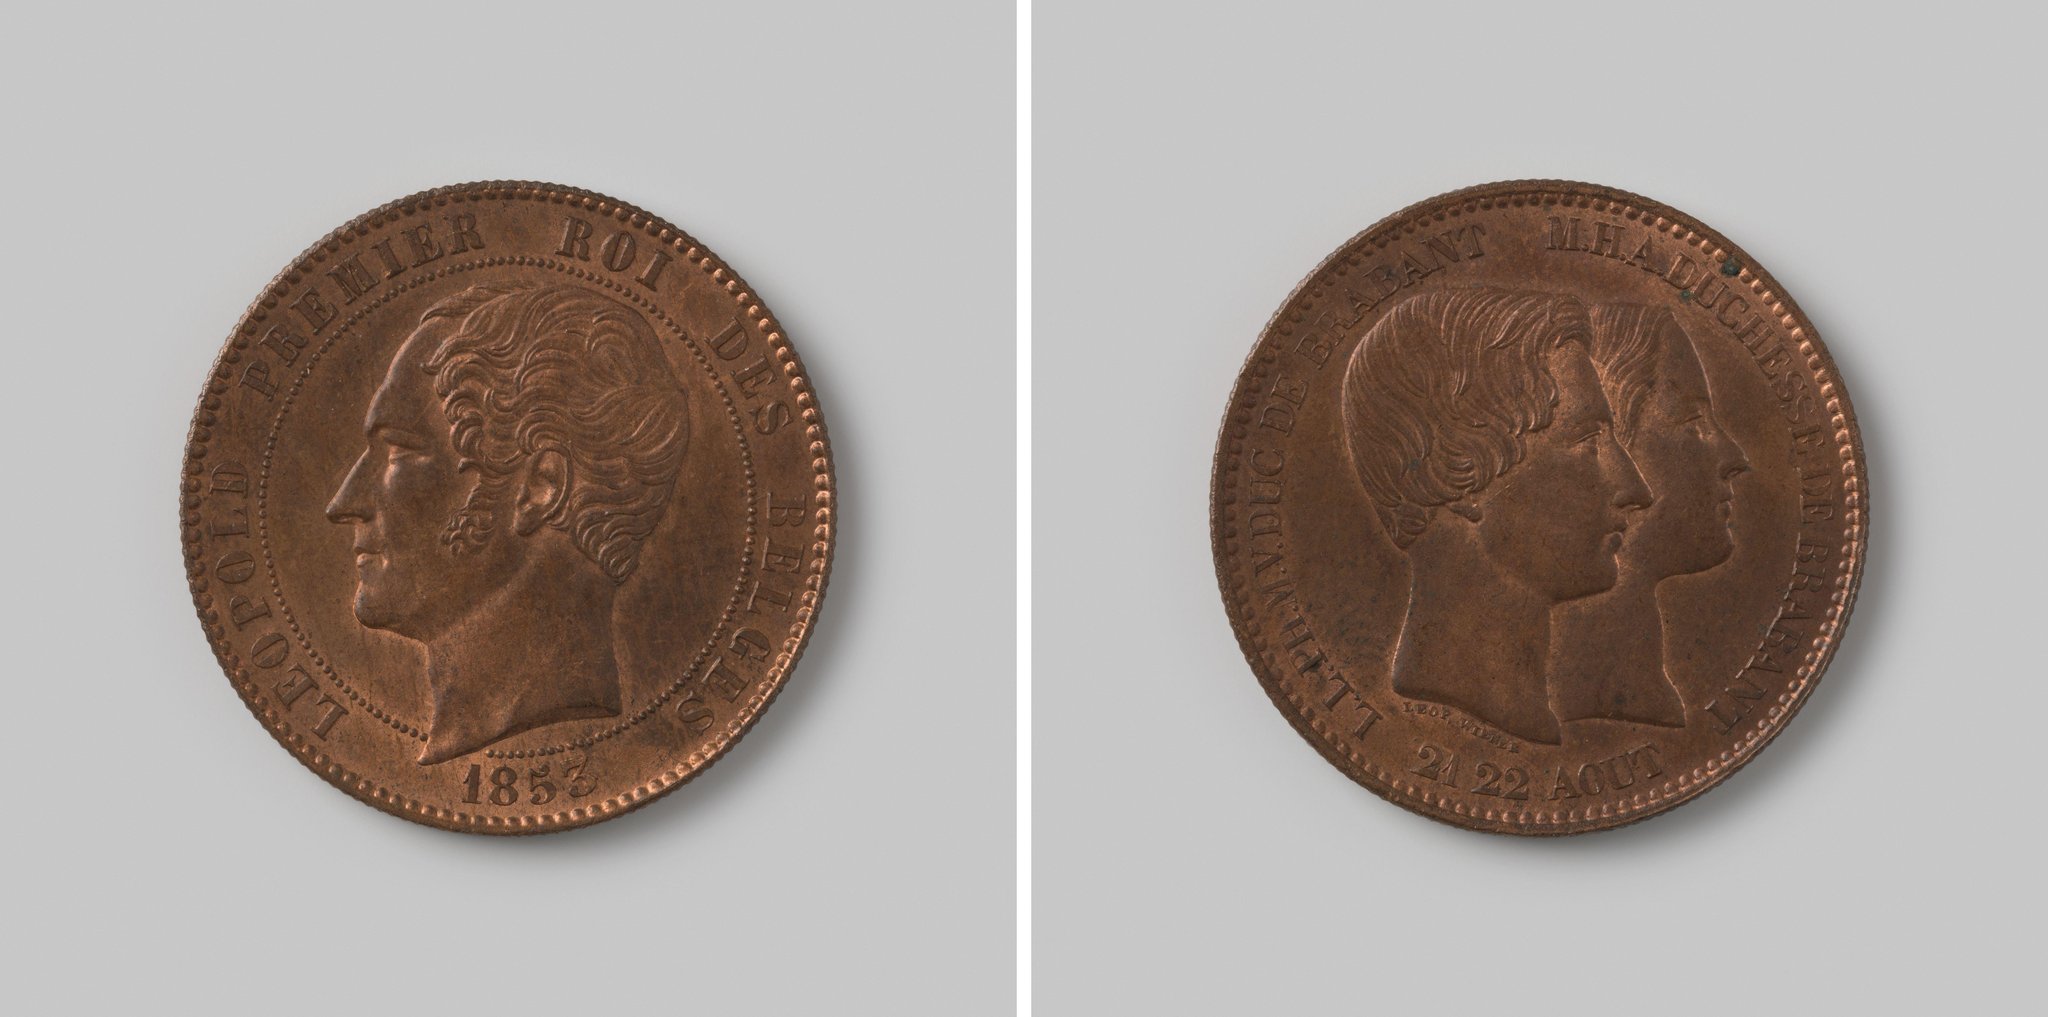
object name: history medal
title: Huwelijk van de Hertog van Brabant 1853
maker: leopold wiener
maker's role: sculptor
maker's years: 1823-1891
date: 1853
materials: bronze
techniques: striking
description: Koperen penning op het formaat van een 10-centimesstuk, op de voorzijde het portret van Koning Leopold I met omschrift, op de keerzijde een dubbelportret van het bruidspaar met omschrift, met kartelrand.